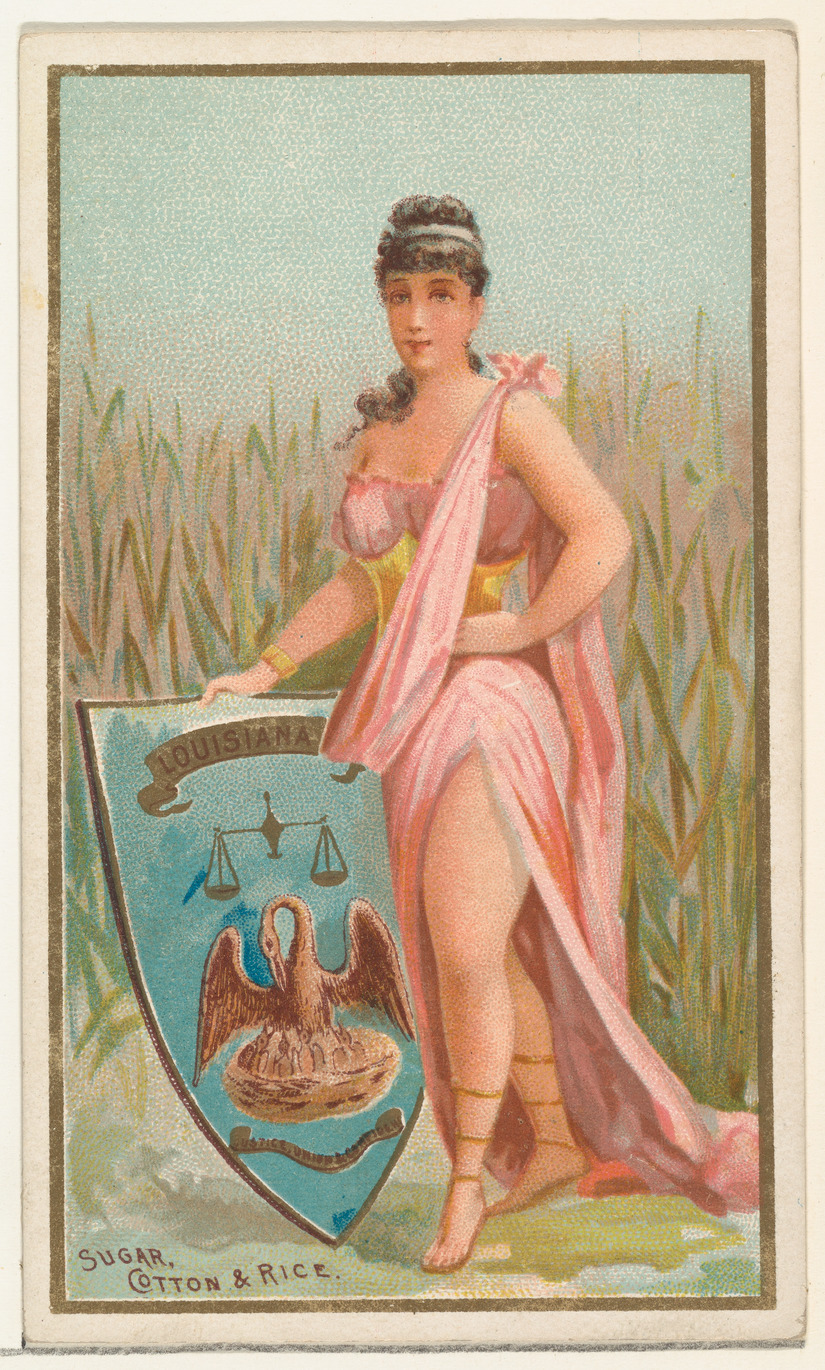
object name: print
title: Louisiana, from the Industries of States series (N117) issued by Duke Sons & Co. to promote Honest Long Cut Tobacco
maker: w. duke, sons & co.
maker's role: publisher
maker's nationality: american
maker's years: 1870-1920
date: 1889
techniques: color lithograph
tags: shields,women